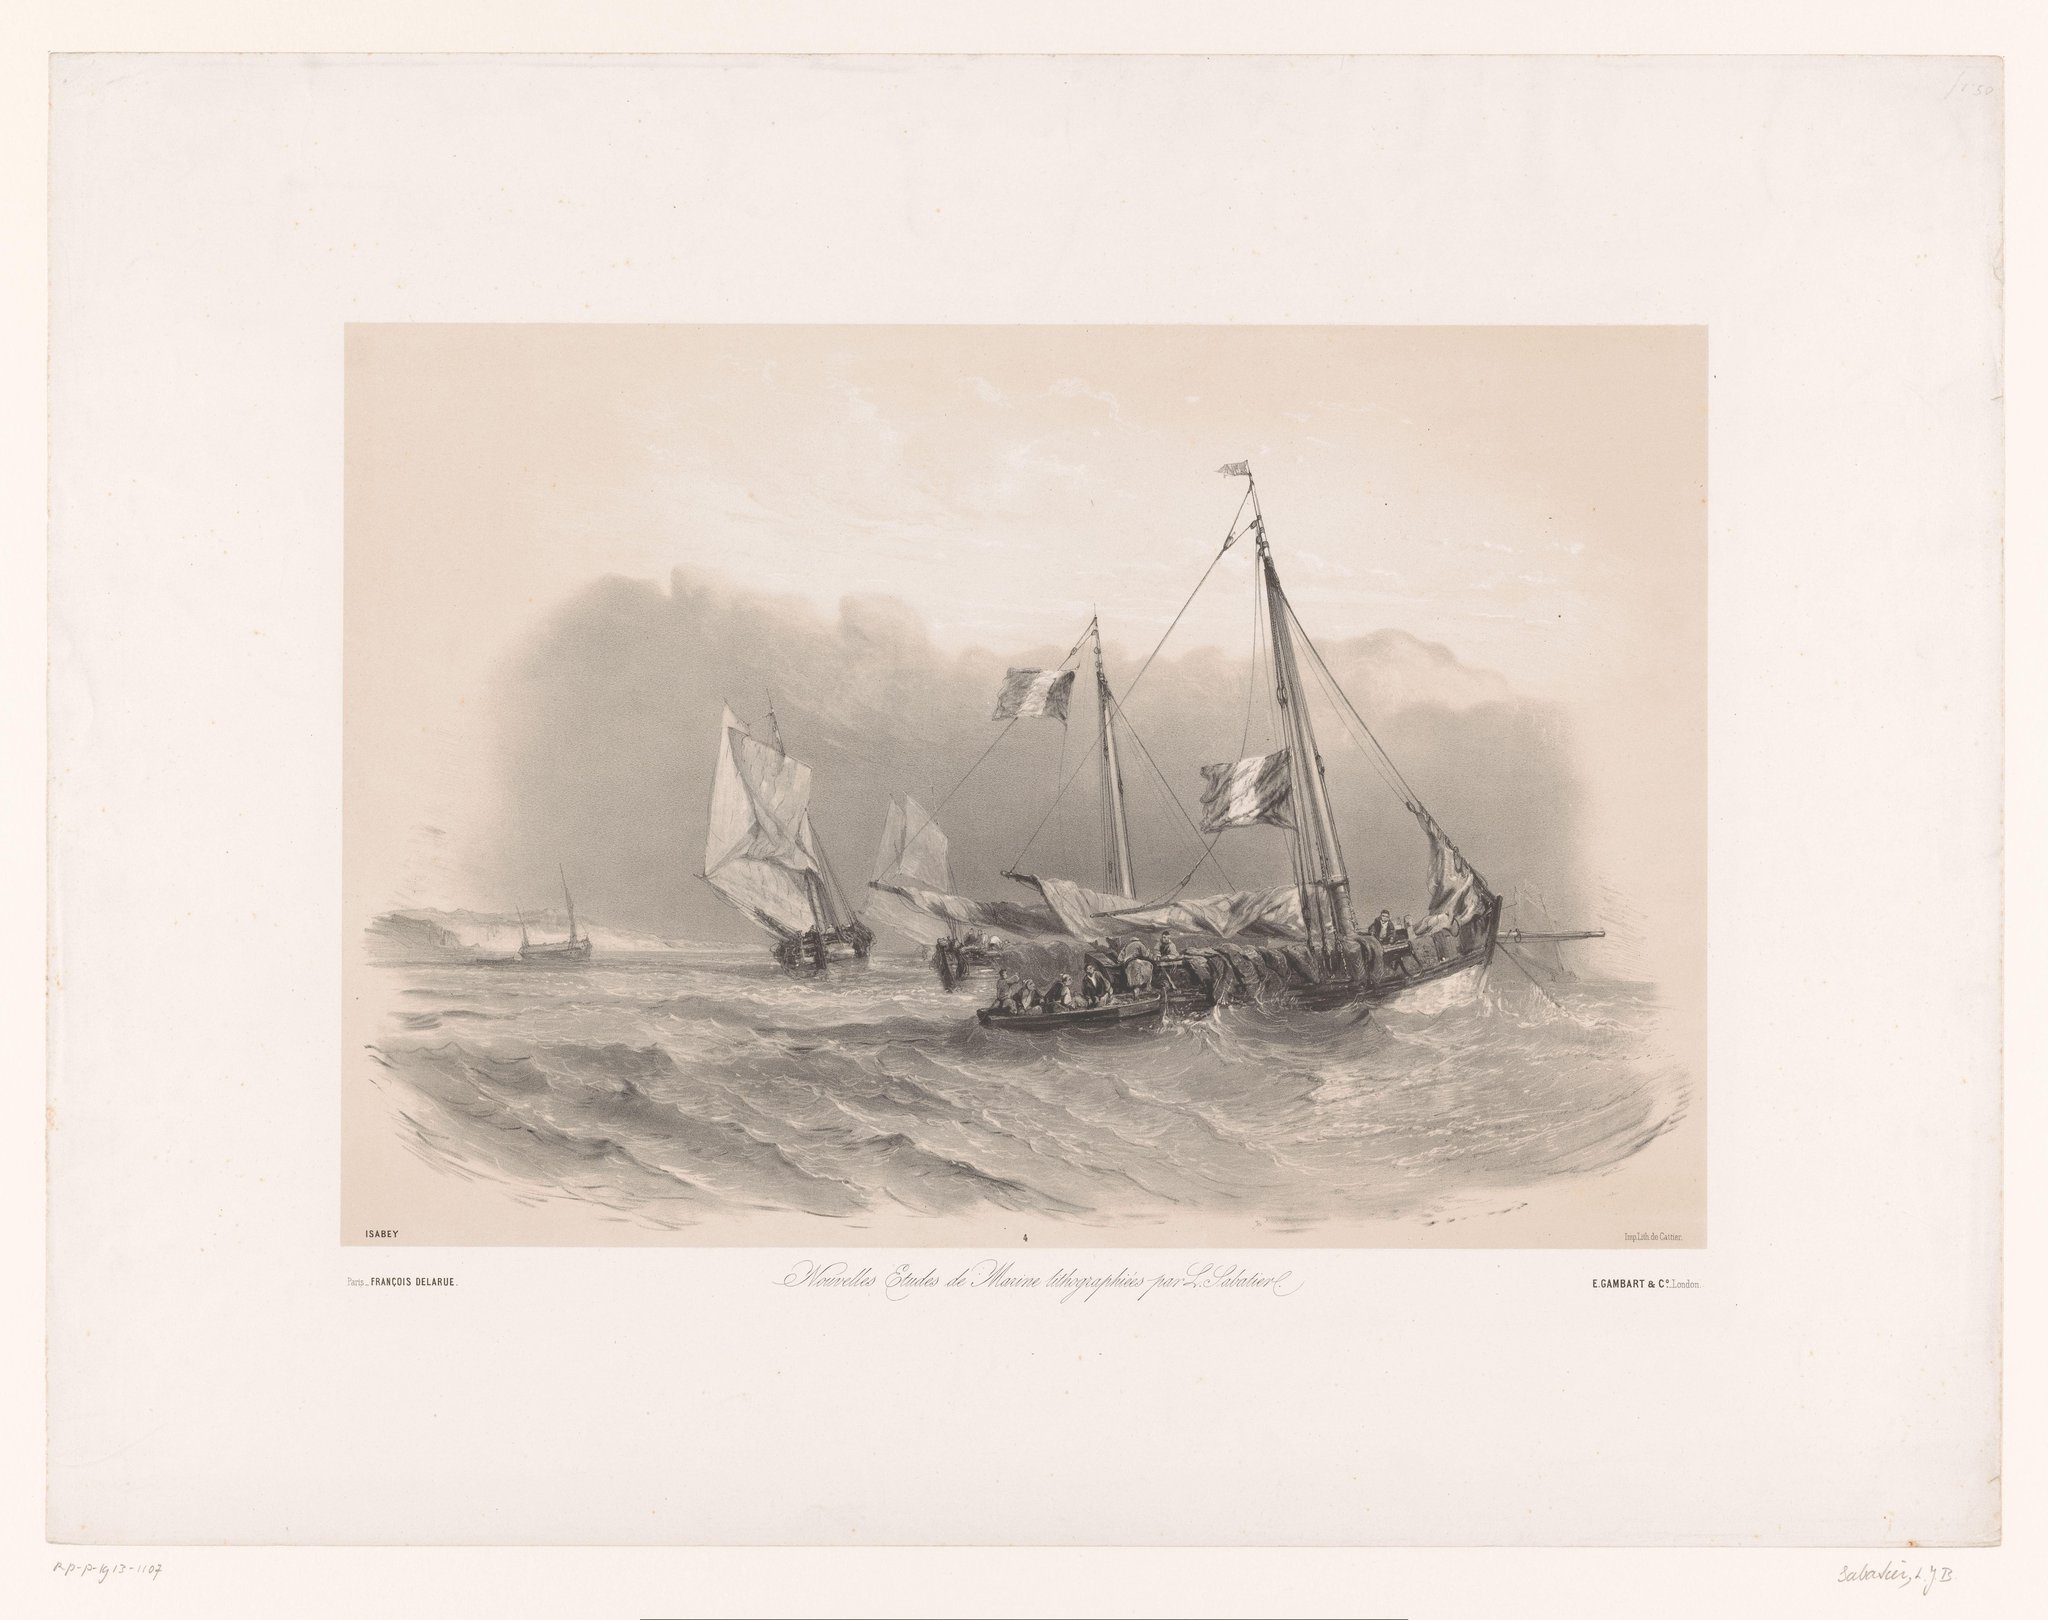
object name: print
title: Franse vissersschepen op zee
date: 1840-1856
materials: paper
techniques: tone lithography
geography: paris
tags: traffic on the water, fisherman, sea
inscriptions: collector's mark: Lugt 2228